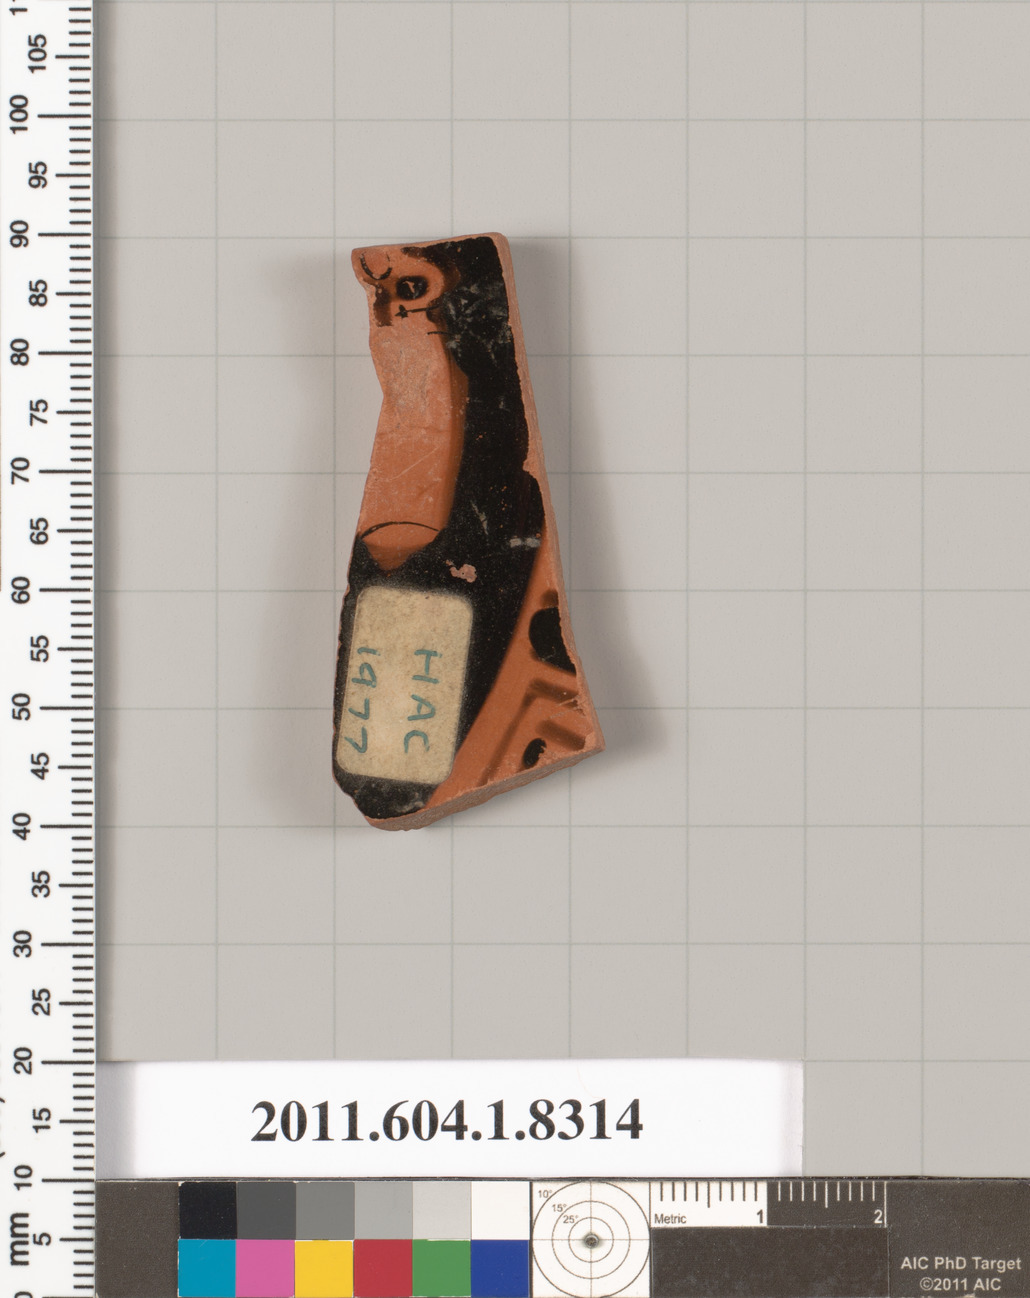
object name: kylix fragment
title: Terracotta fragment of a kylix (drinking cup)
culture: greek, attic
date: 400-351 BCE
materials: terracotta